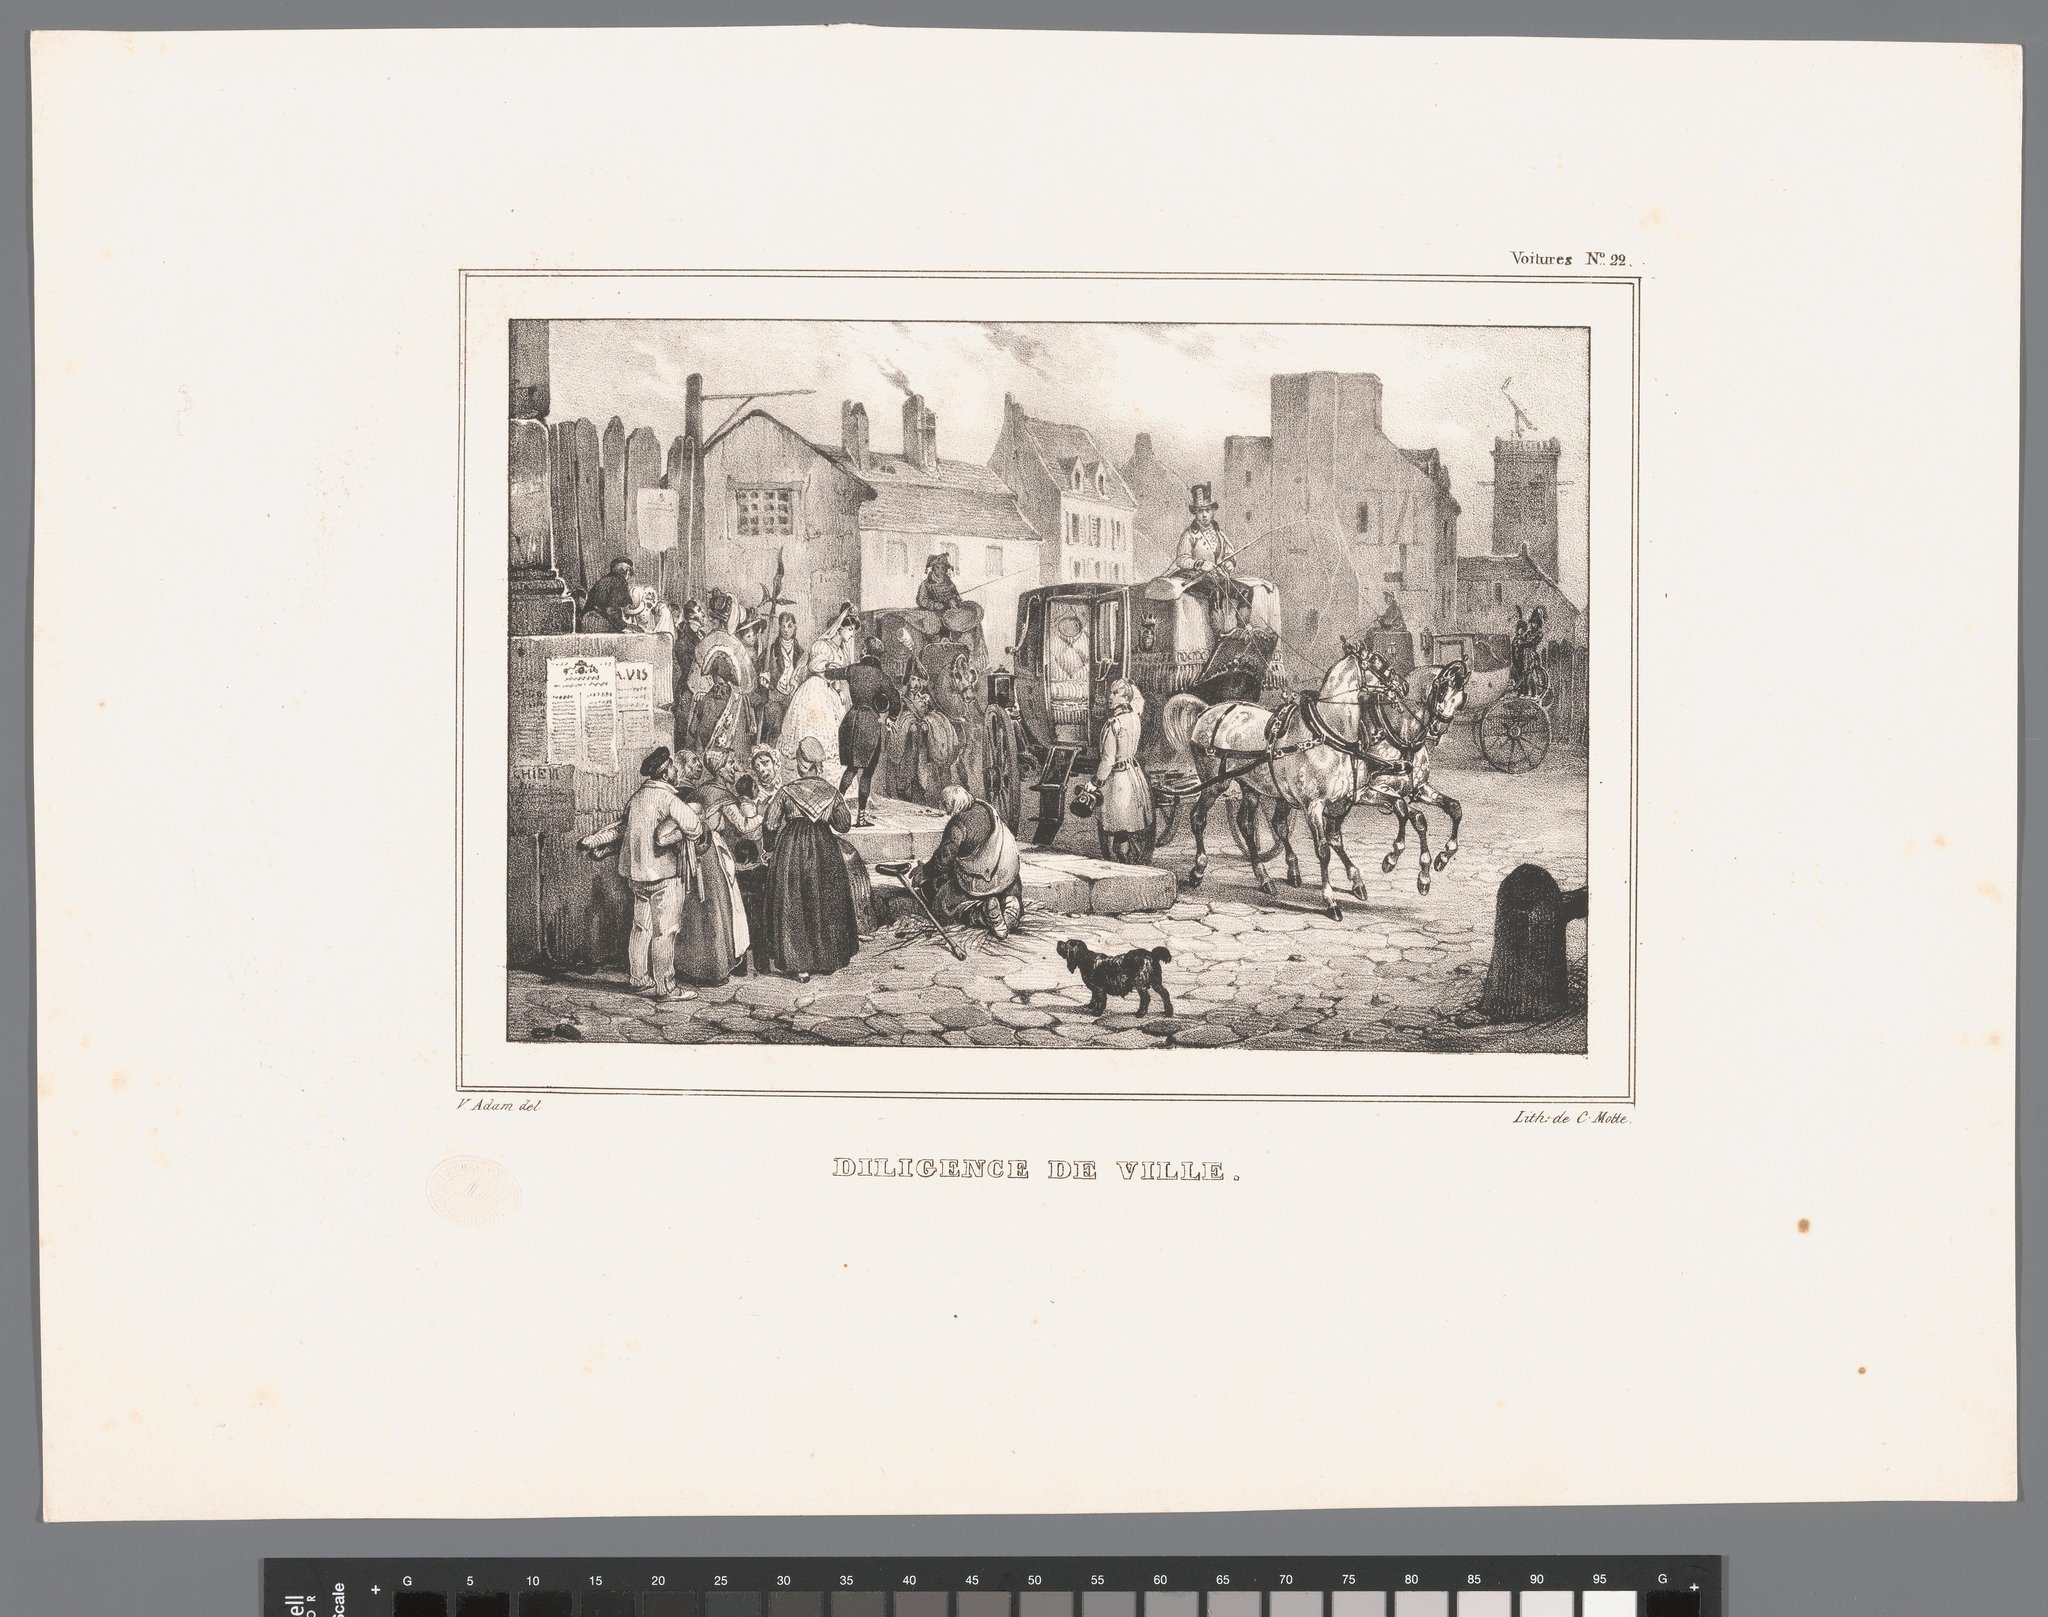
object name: print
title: Panidochème ou toutes sortes de voitures (2)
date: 1828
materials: paper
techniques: lithograph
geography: paris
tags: diligence, omnibus, horse-tram, four-wheeled vehicle drawn by two animals, passenger carriage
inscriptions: collector's mark: Lugt 2228, stamp: Lugt 1828b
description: De prentserie waar deze prent deel van uitmaakt werd in drie delen van twaalf prenten vanaf 1827 tot en met 1830 gepubliceerd. Elk van de drie delen werd voorzien van een aparte omslag. De diligence was een geveerde postkoets, die op regelmatige tijden ook openbaar vervoer aan reizigers bood.